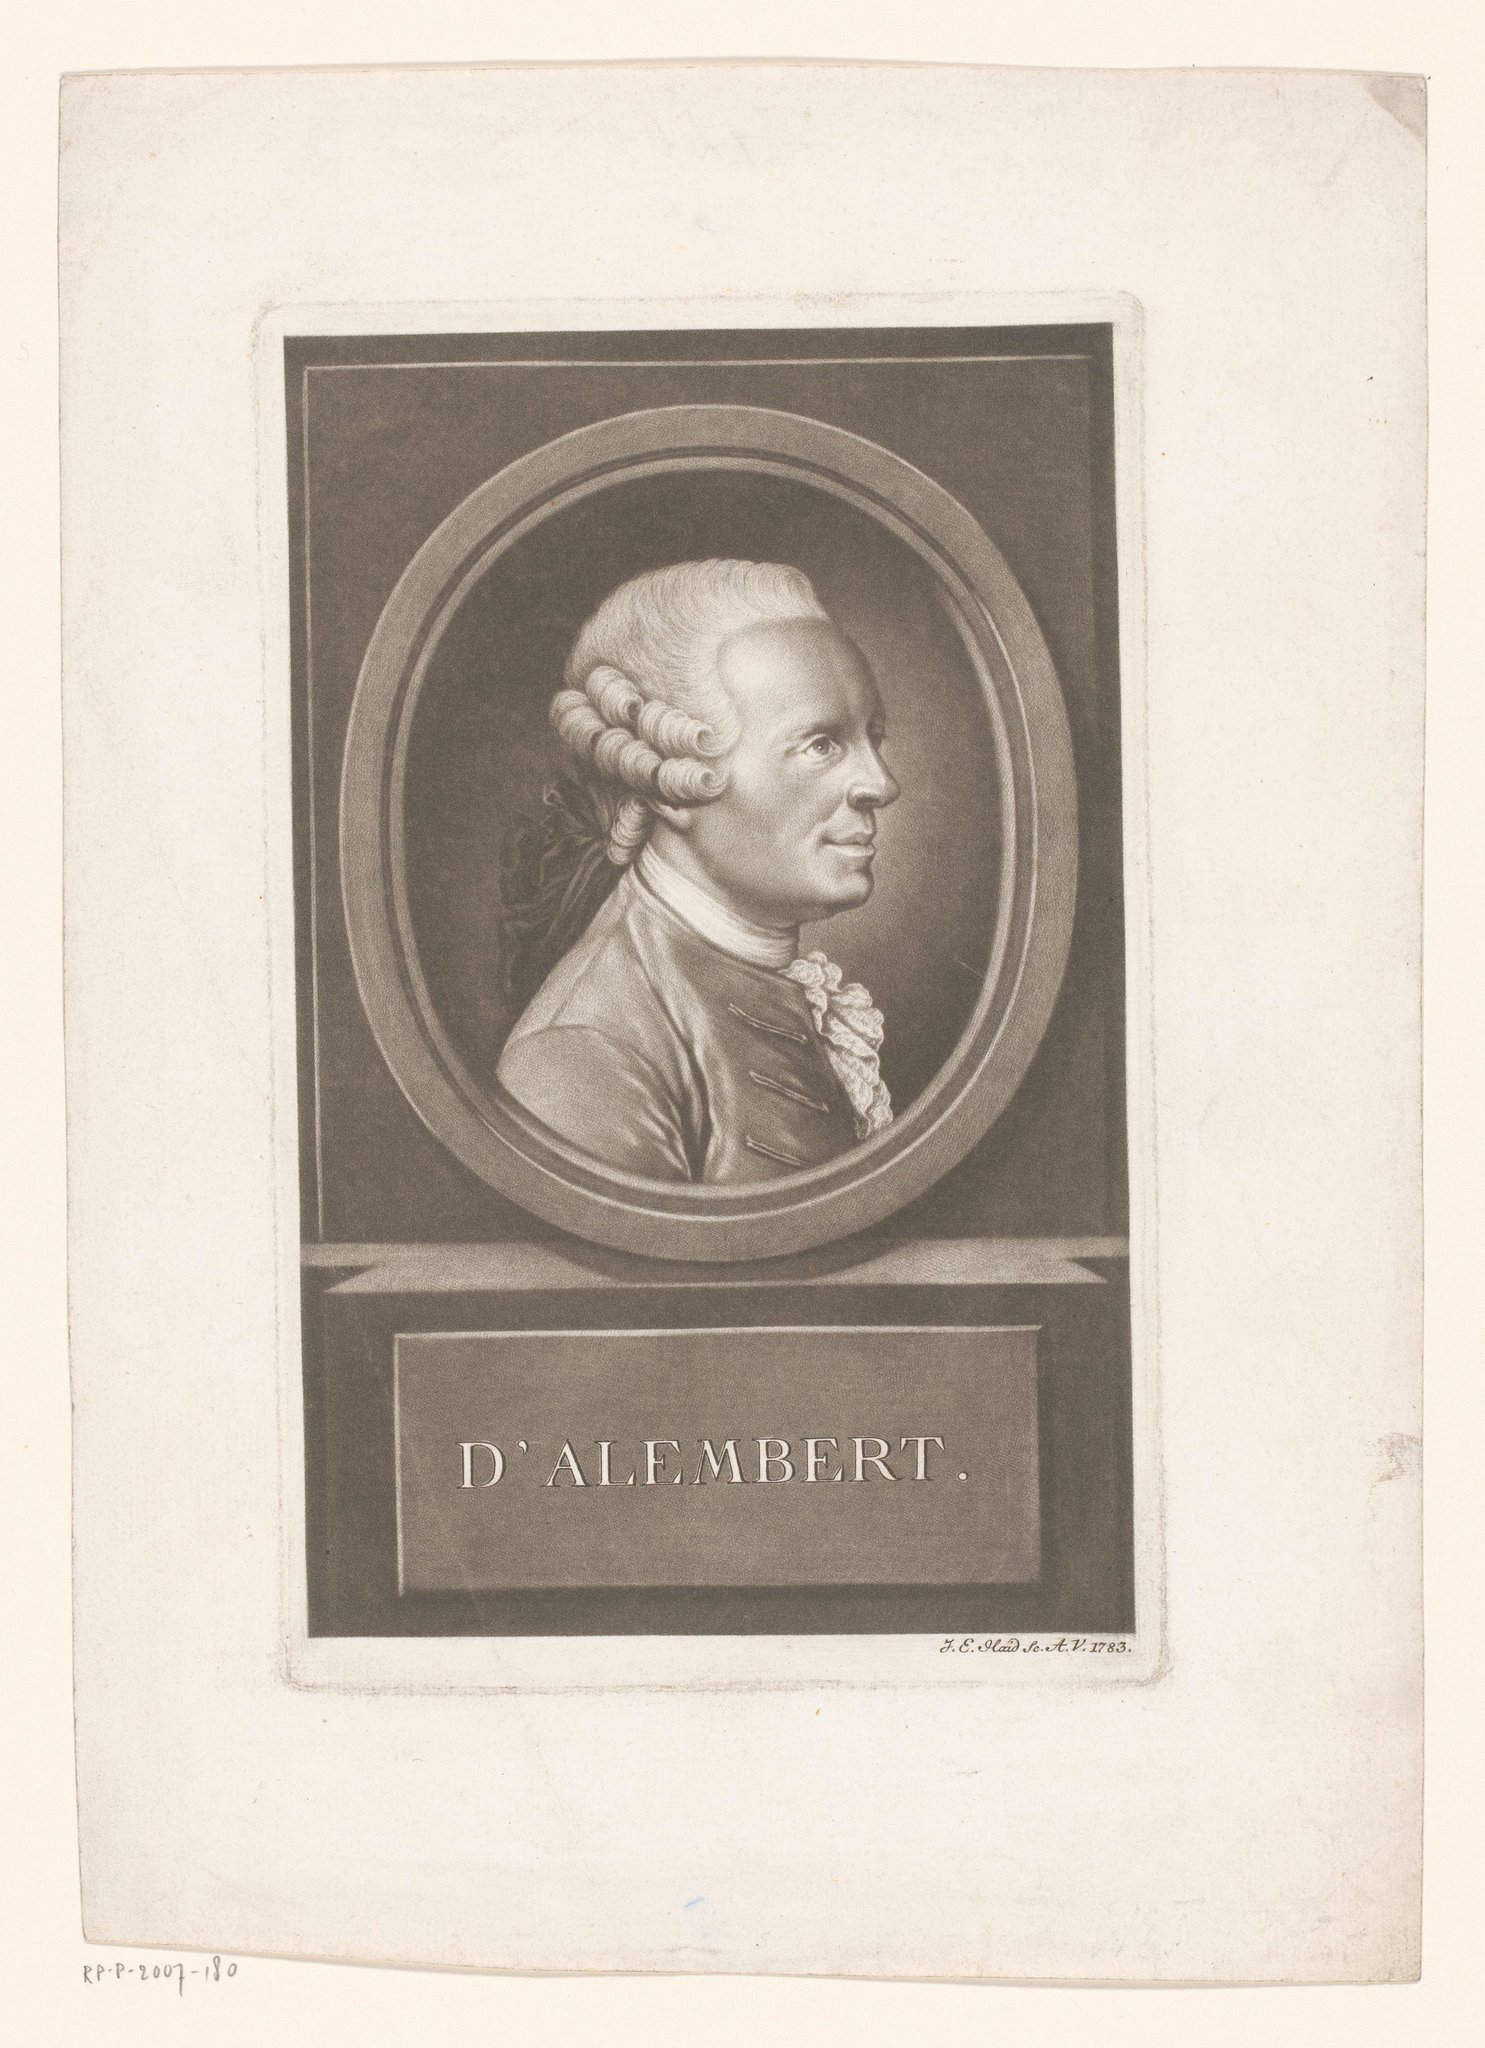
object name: print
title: Portret van Jean Le Rond d'Alembert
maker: johann elias haid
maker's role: print maker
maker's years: 1739-1809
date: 1783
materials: paper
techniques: mezzotint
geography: augsburg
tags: paris, physicist, historical persons, portrait of a writer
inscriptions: collector's mark: Lugt 2228, collector's mark: Lugt 2760